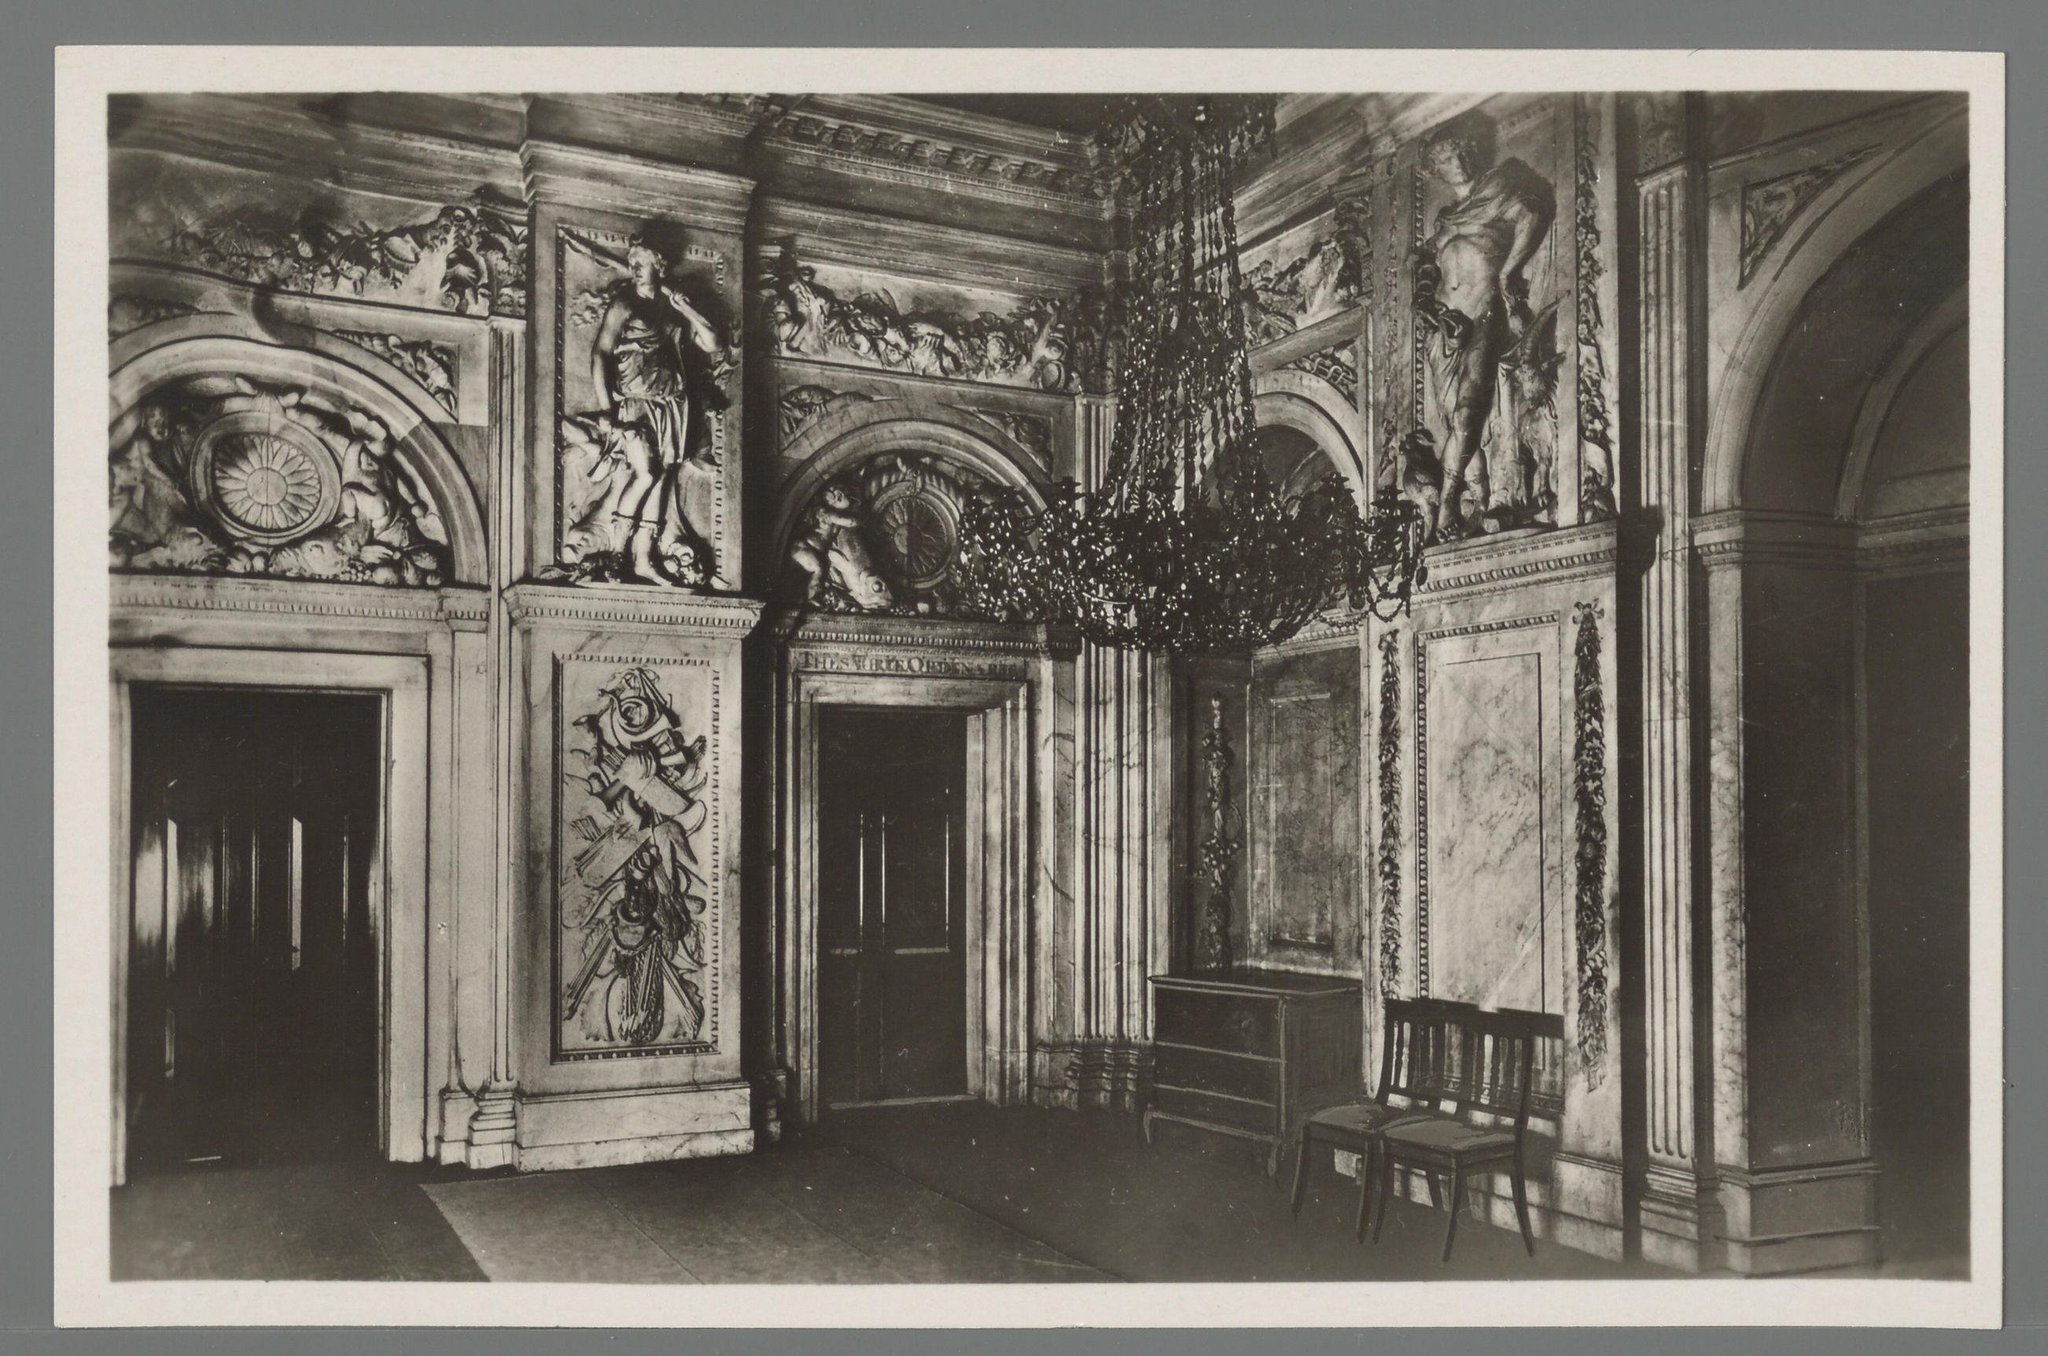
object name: ansichtkaart, prentbriefkaart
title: Koninklijk Paleis Amsterdam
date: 1932-1947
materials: photographic support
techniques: photography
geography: the hague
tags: palace - aa - civic architecture: inside, decorations (interior of the house), vestibule, hall, royal palace of amsterdam